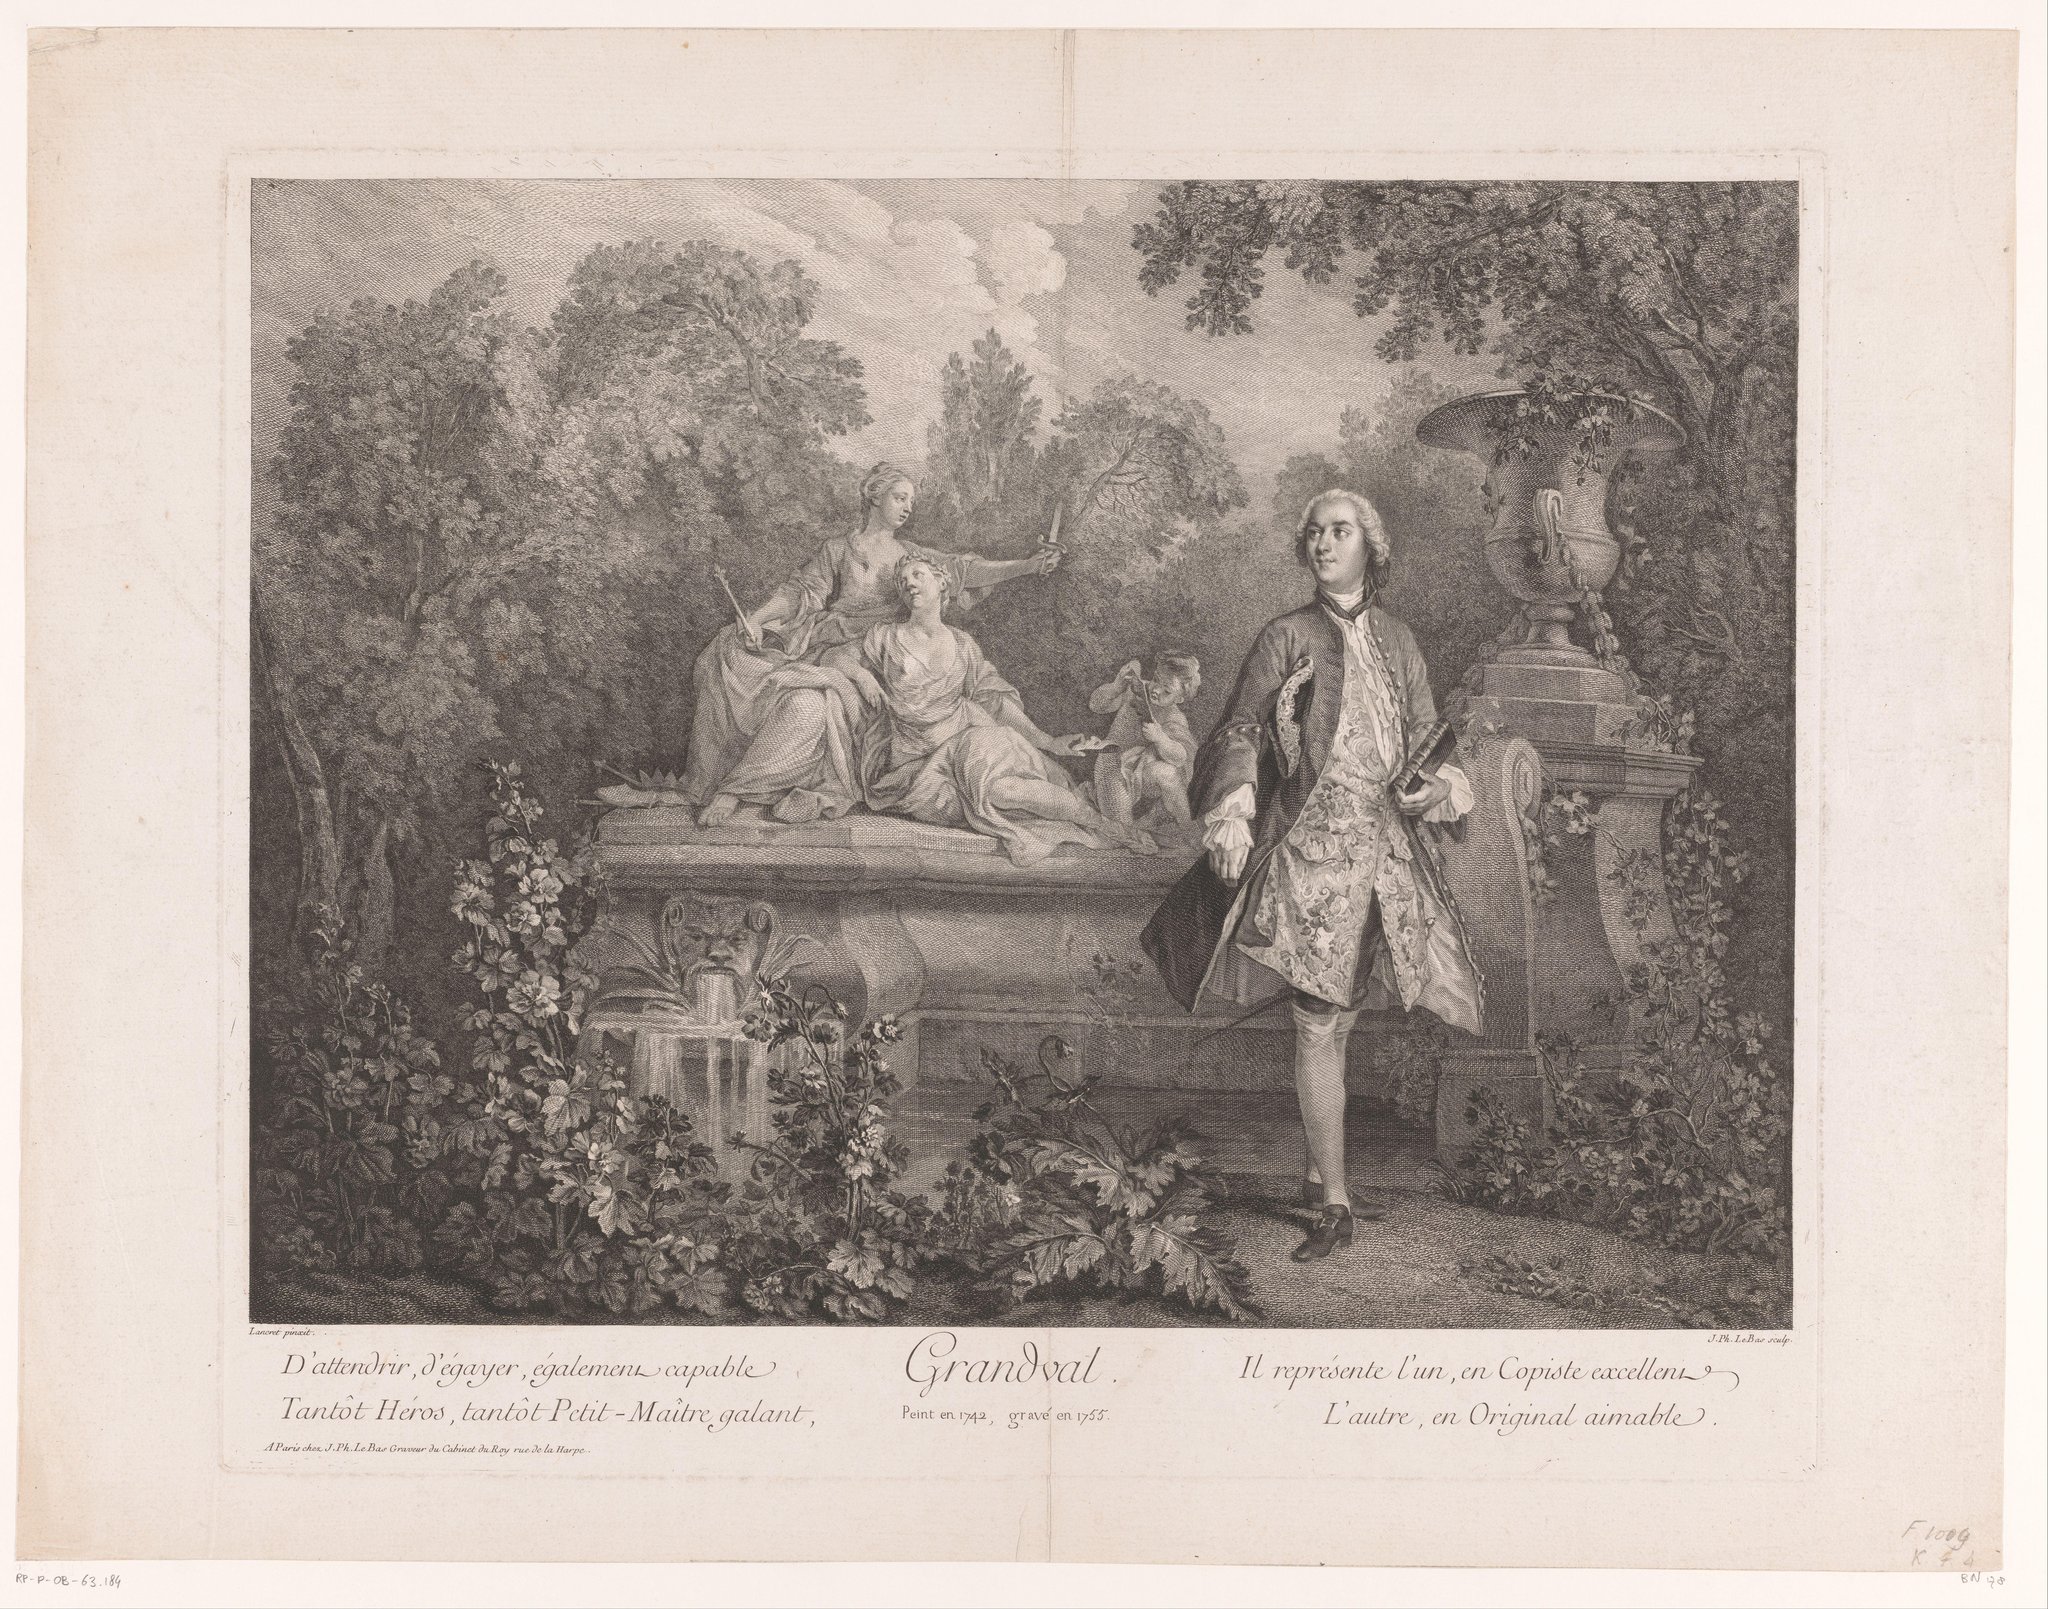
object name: print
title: Grandval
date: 1755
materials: paper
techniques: engraving, etching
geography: paris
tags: historical persons, portrait of actor, actress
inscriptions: collector's mark: Lugt 240